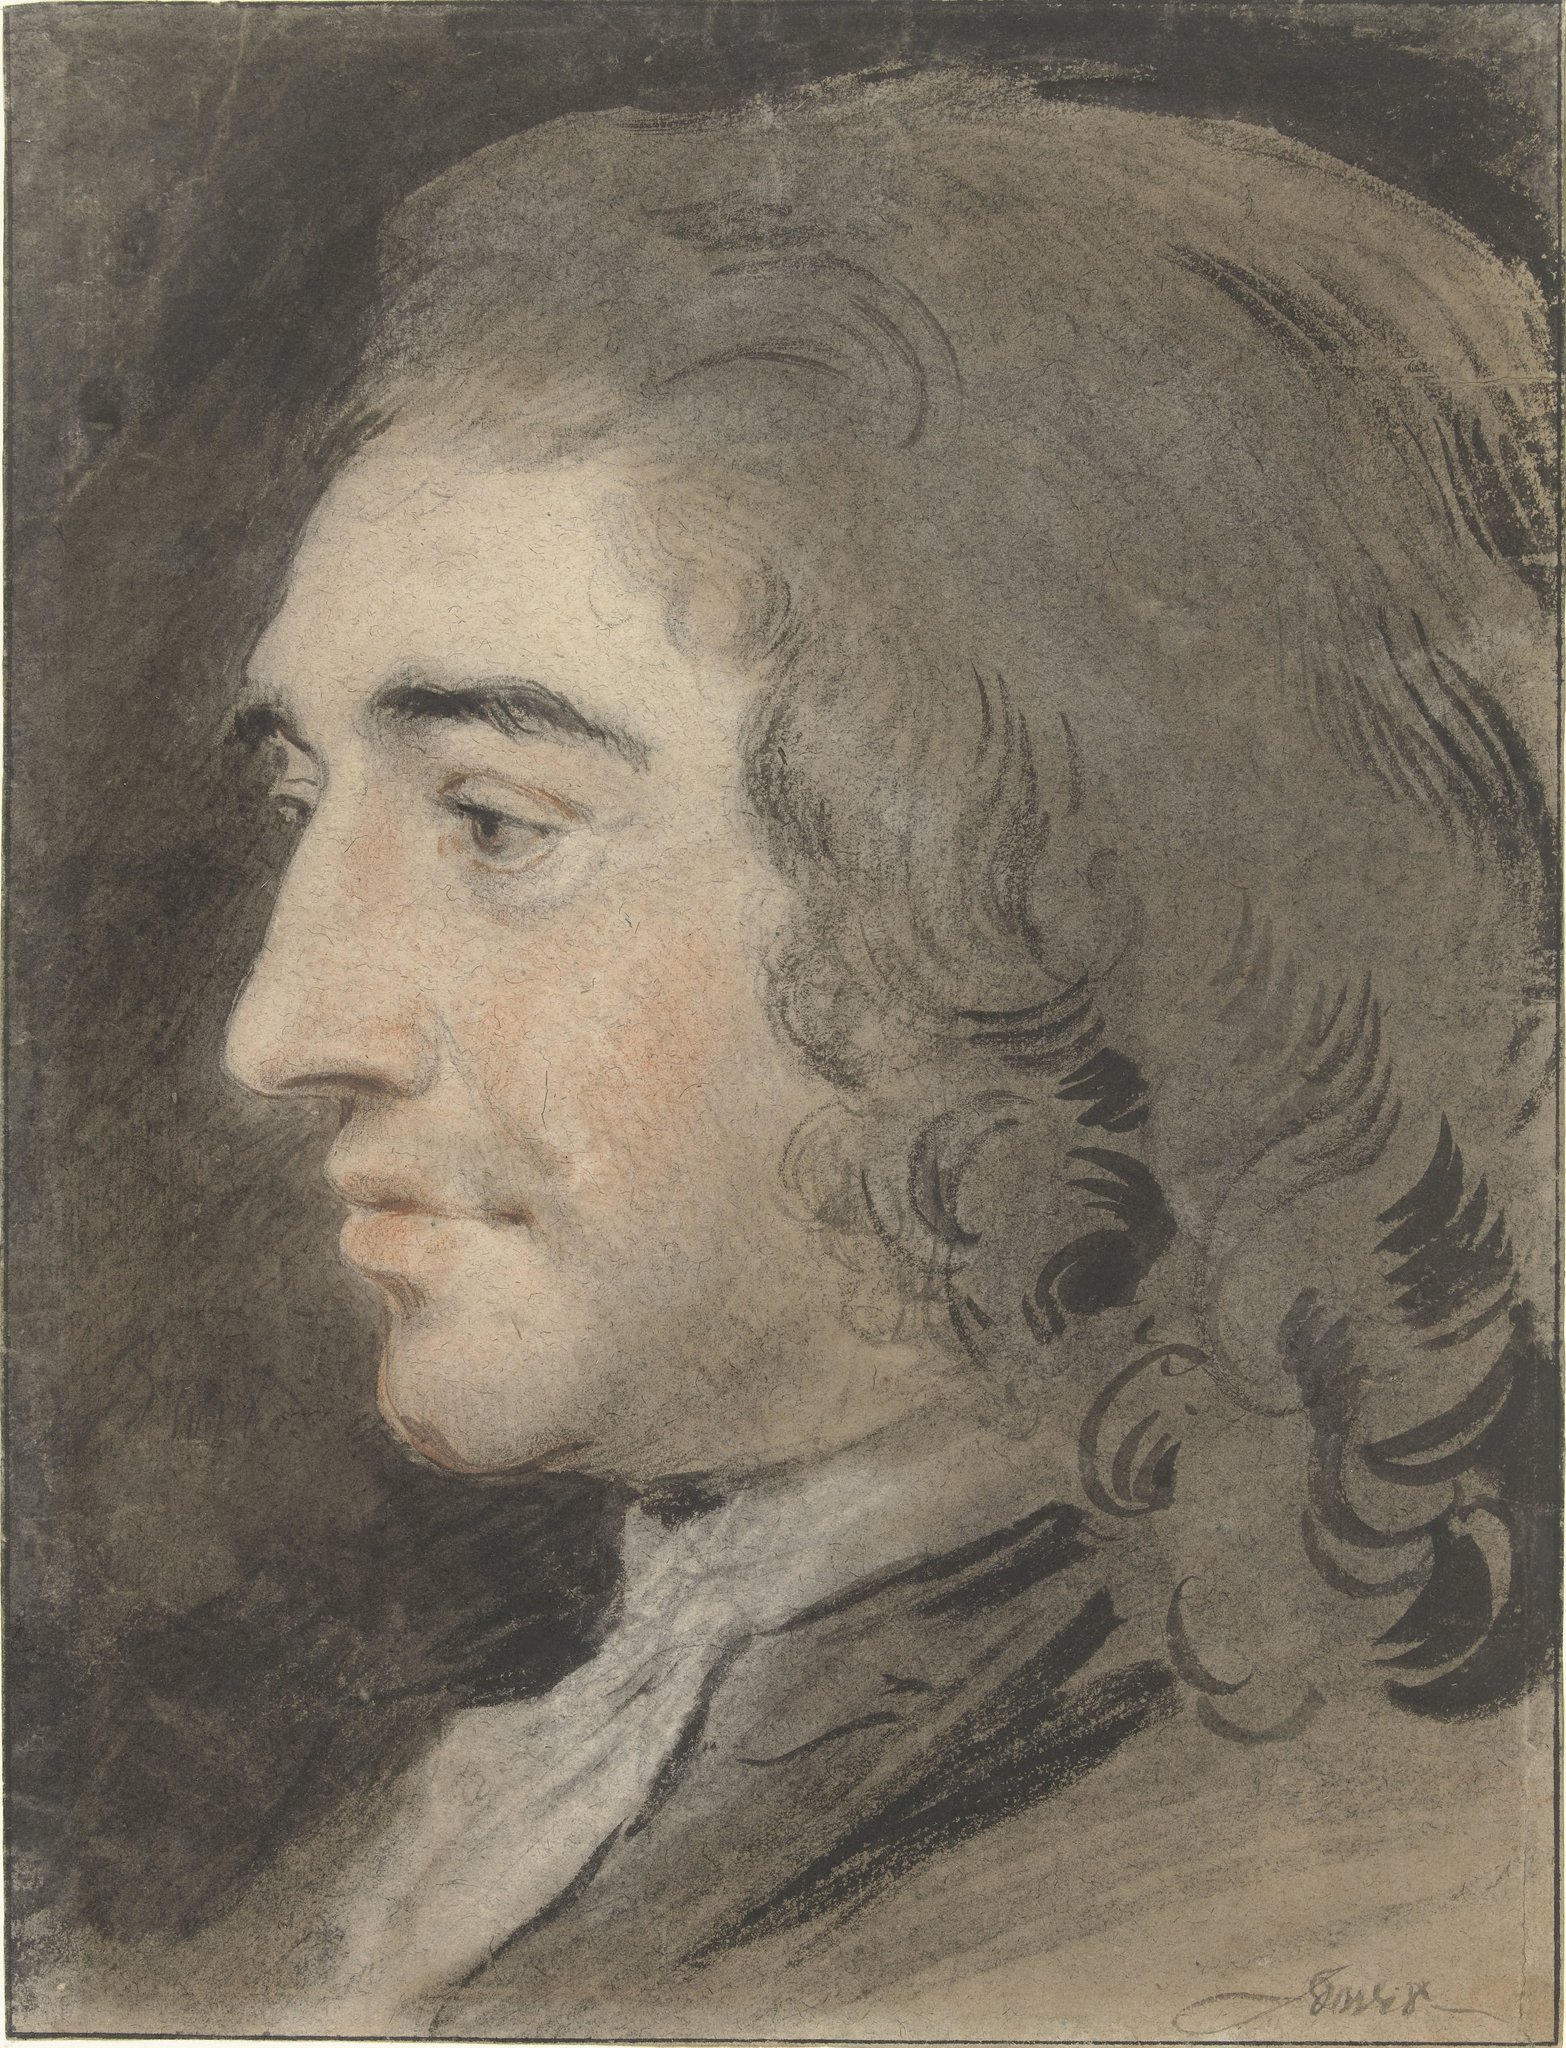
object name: drawing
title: Mansportret, naar links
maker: jacob de wit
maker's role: draughtsman, painter, print maker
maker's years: 1695-1754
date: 1705-1754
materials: chalk, paper, pencil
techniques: brush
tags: head (human), anonymous historical person portrayed alone